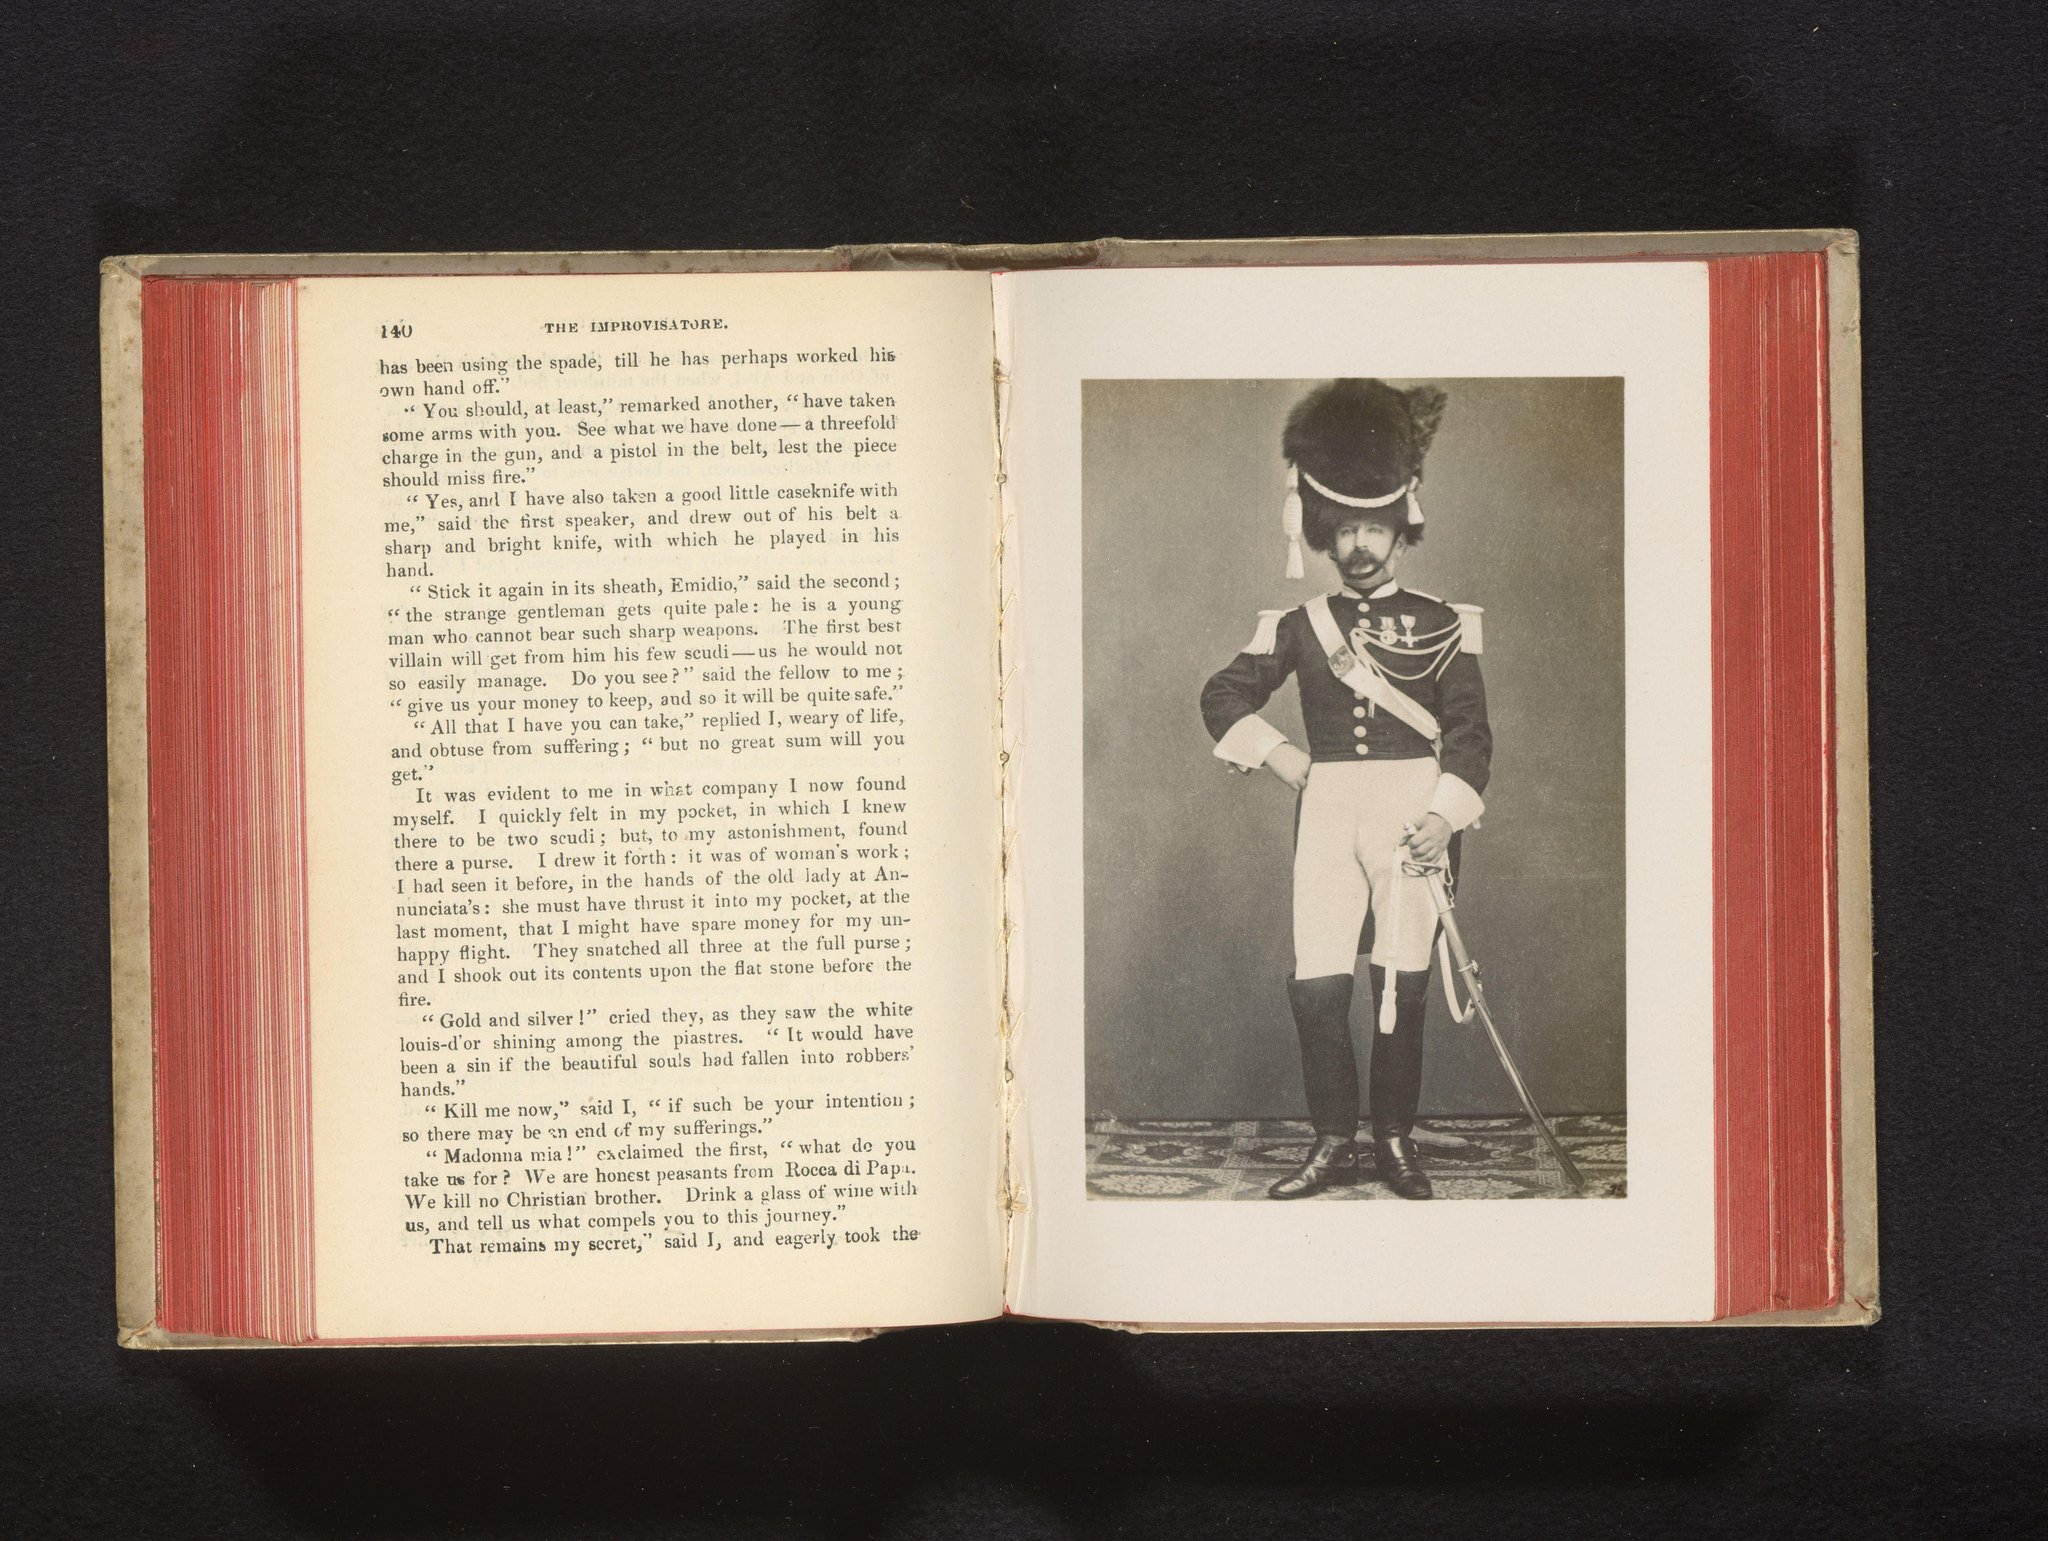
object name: page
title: Portret van (vermoedelijk) een grenadier in uniform met een berenmuts en sabel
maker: Anonymous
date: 1870-1880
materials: photographic support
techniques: gelatin silver print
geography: rome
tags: head-gear, the soldier; the soldier's life